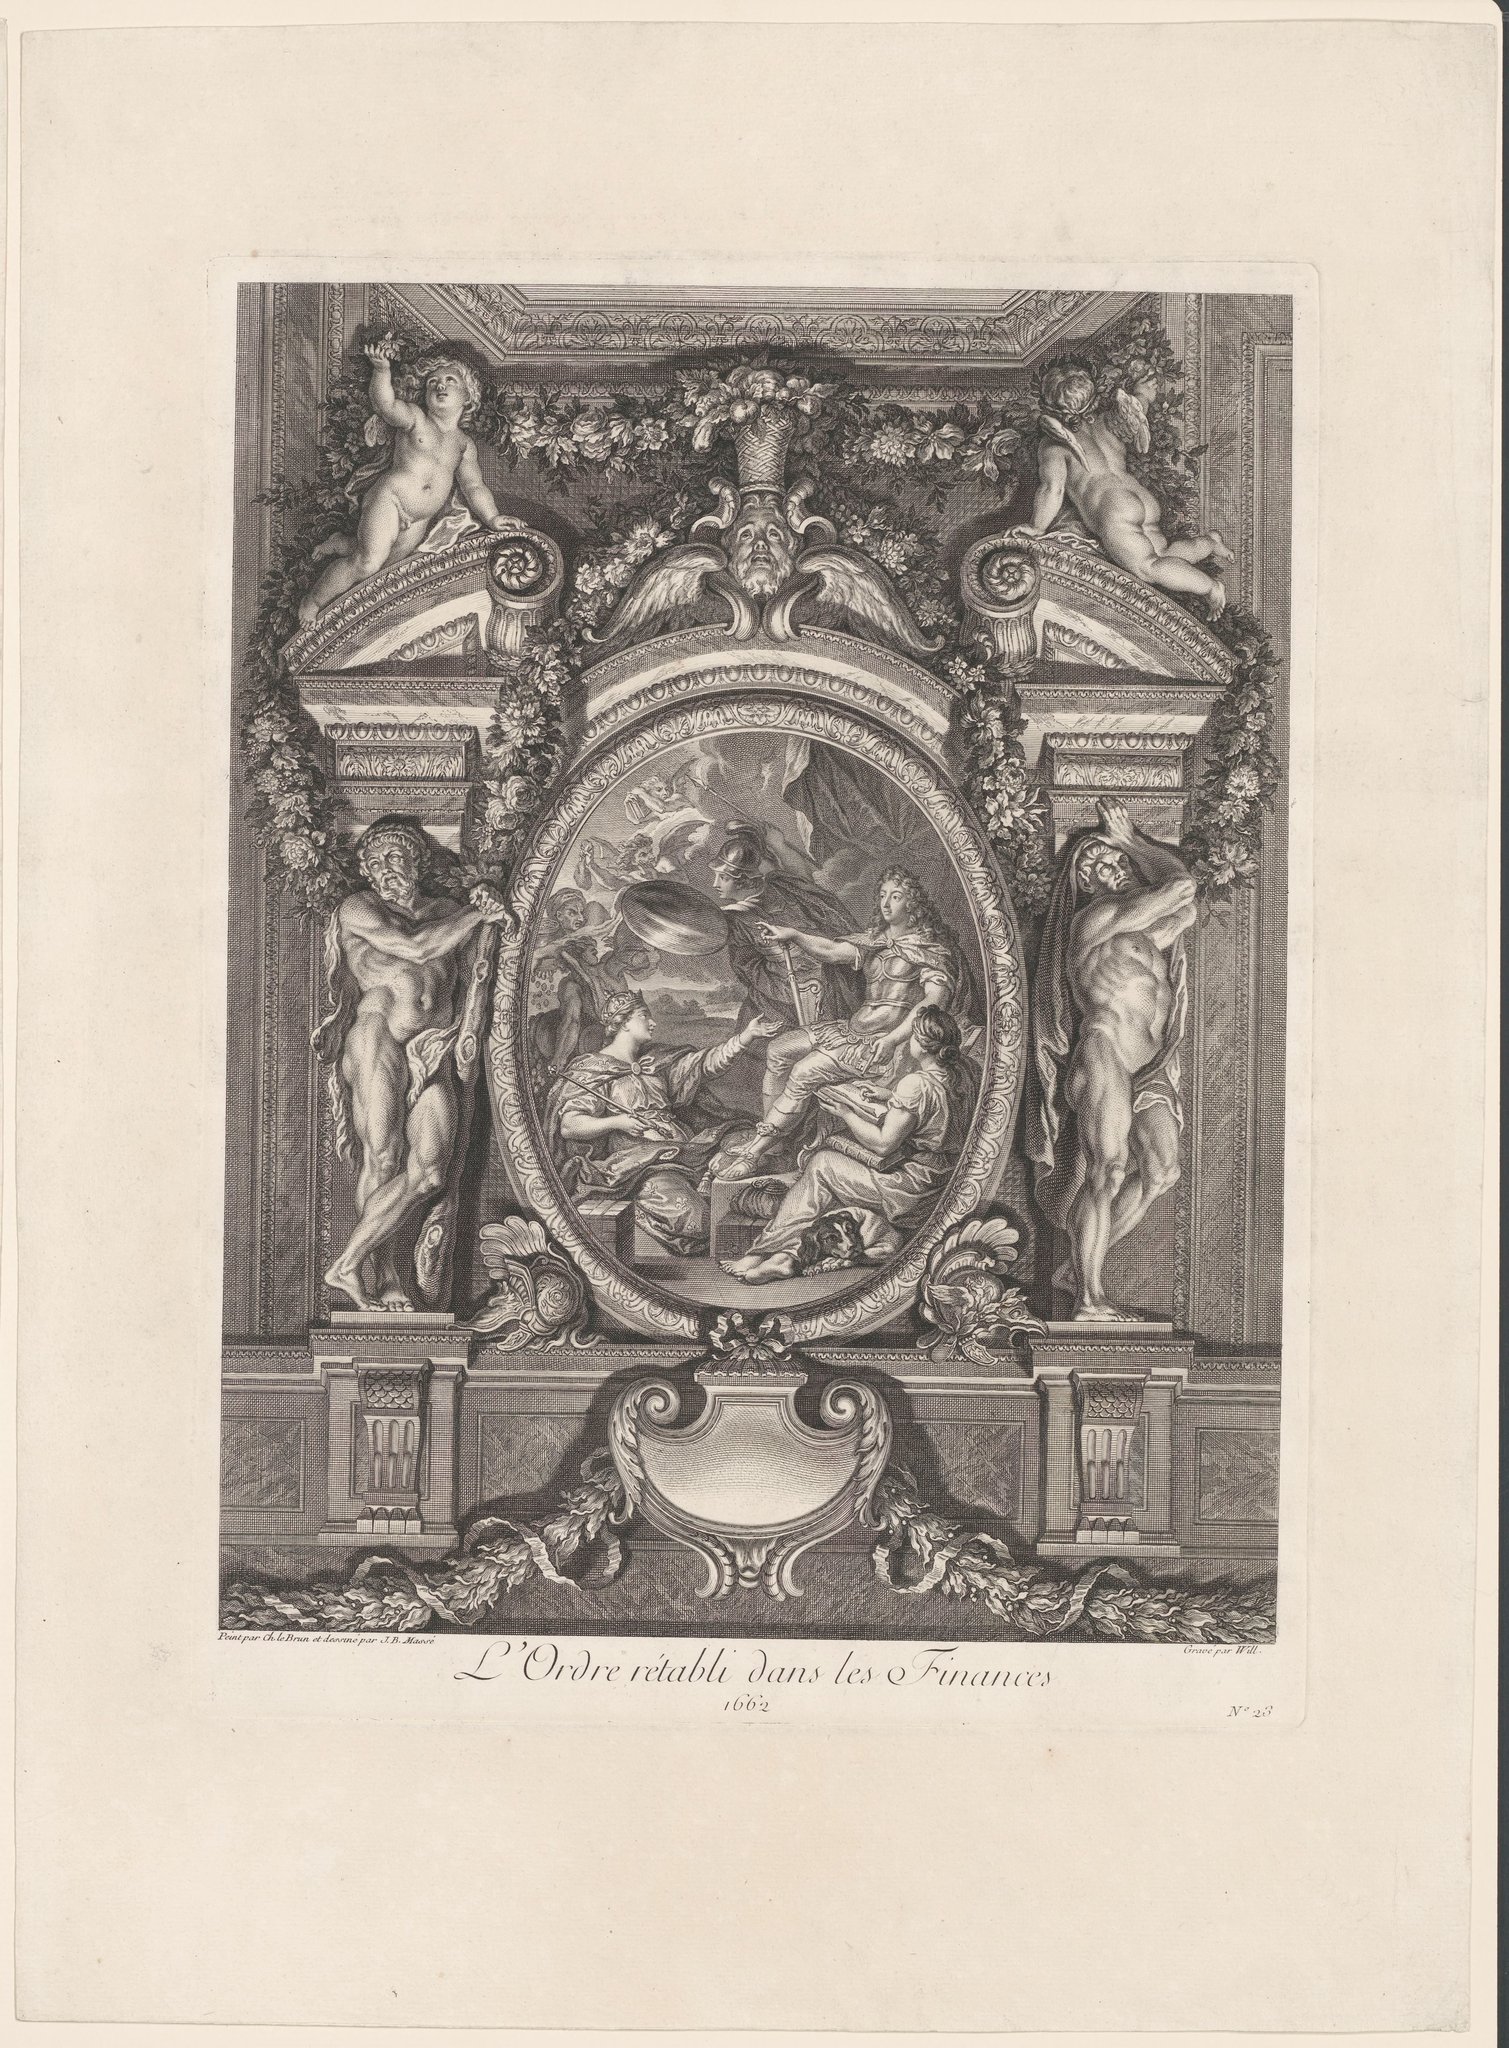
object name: print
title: L'ouvrage de Charles le Brun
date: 1725-1808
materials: paper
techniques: engraving, etching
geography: germany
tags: lodewijk xiv (koning van frankrijk), organization of trade and finance, book-keeping, accountant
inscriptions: collector's mark: Lugt 2228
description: Prent uit: Massé, Jean Baptiste. La Grande Galerie de Versailles, et les deux salons qui l'accompagnent, peints par Charles le Brun premier peintre de Louis XIV, dessinés par Jean- Baptiste Masse peintre et conseiller de l'Academie royale de peinture & sculpture; et gravés sous ses yeux par les meilleurs maitres du tems. Parijs: Imprimerie Royale, 1752.